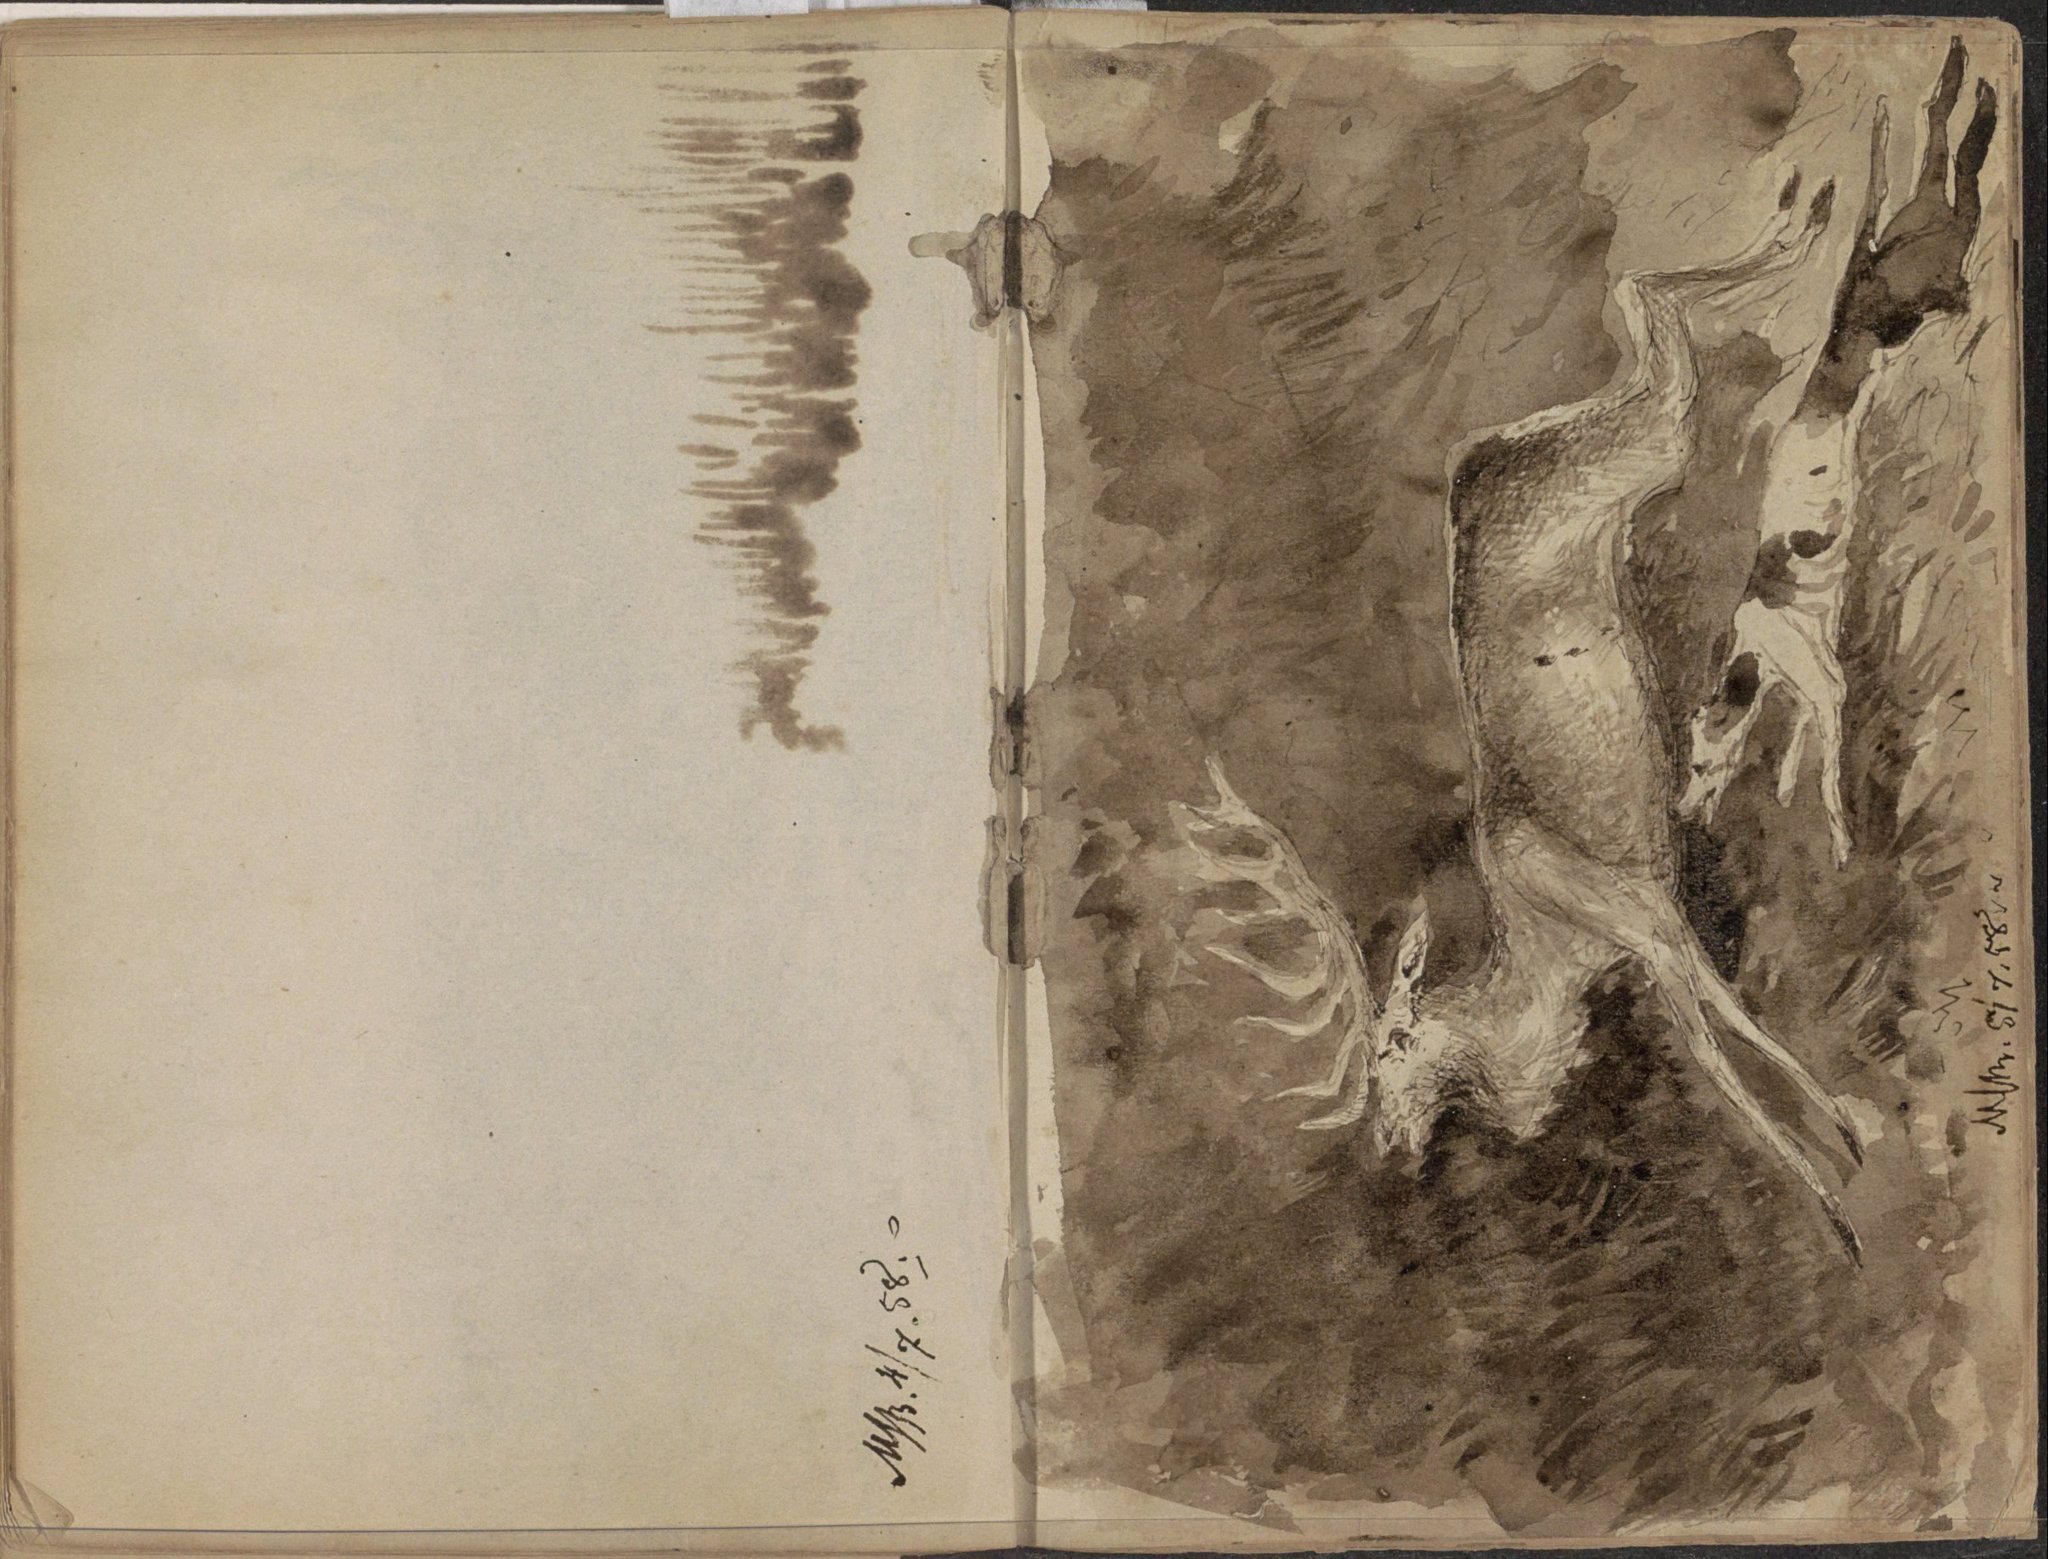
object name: sketchbook leaf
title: Hond jagend op een hert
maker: johannes tavenraat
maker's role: draughtsman, painter, print maker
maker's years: 1809-1881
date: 1807-1858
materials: ink, paper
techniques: brush, pen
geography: bohemia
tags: hoofed animals: deer, dog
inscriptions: date and inscription: ‘MB 4/7. 58./ MB 5/7. 58’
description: Blad 37 verso en 38 recto uit een schetsboek met 44 bladen.